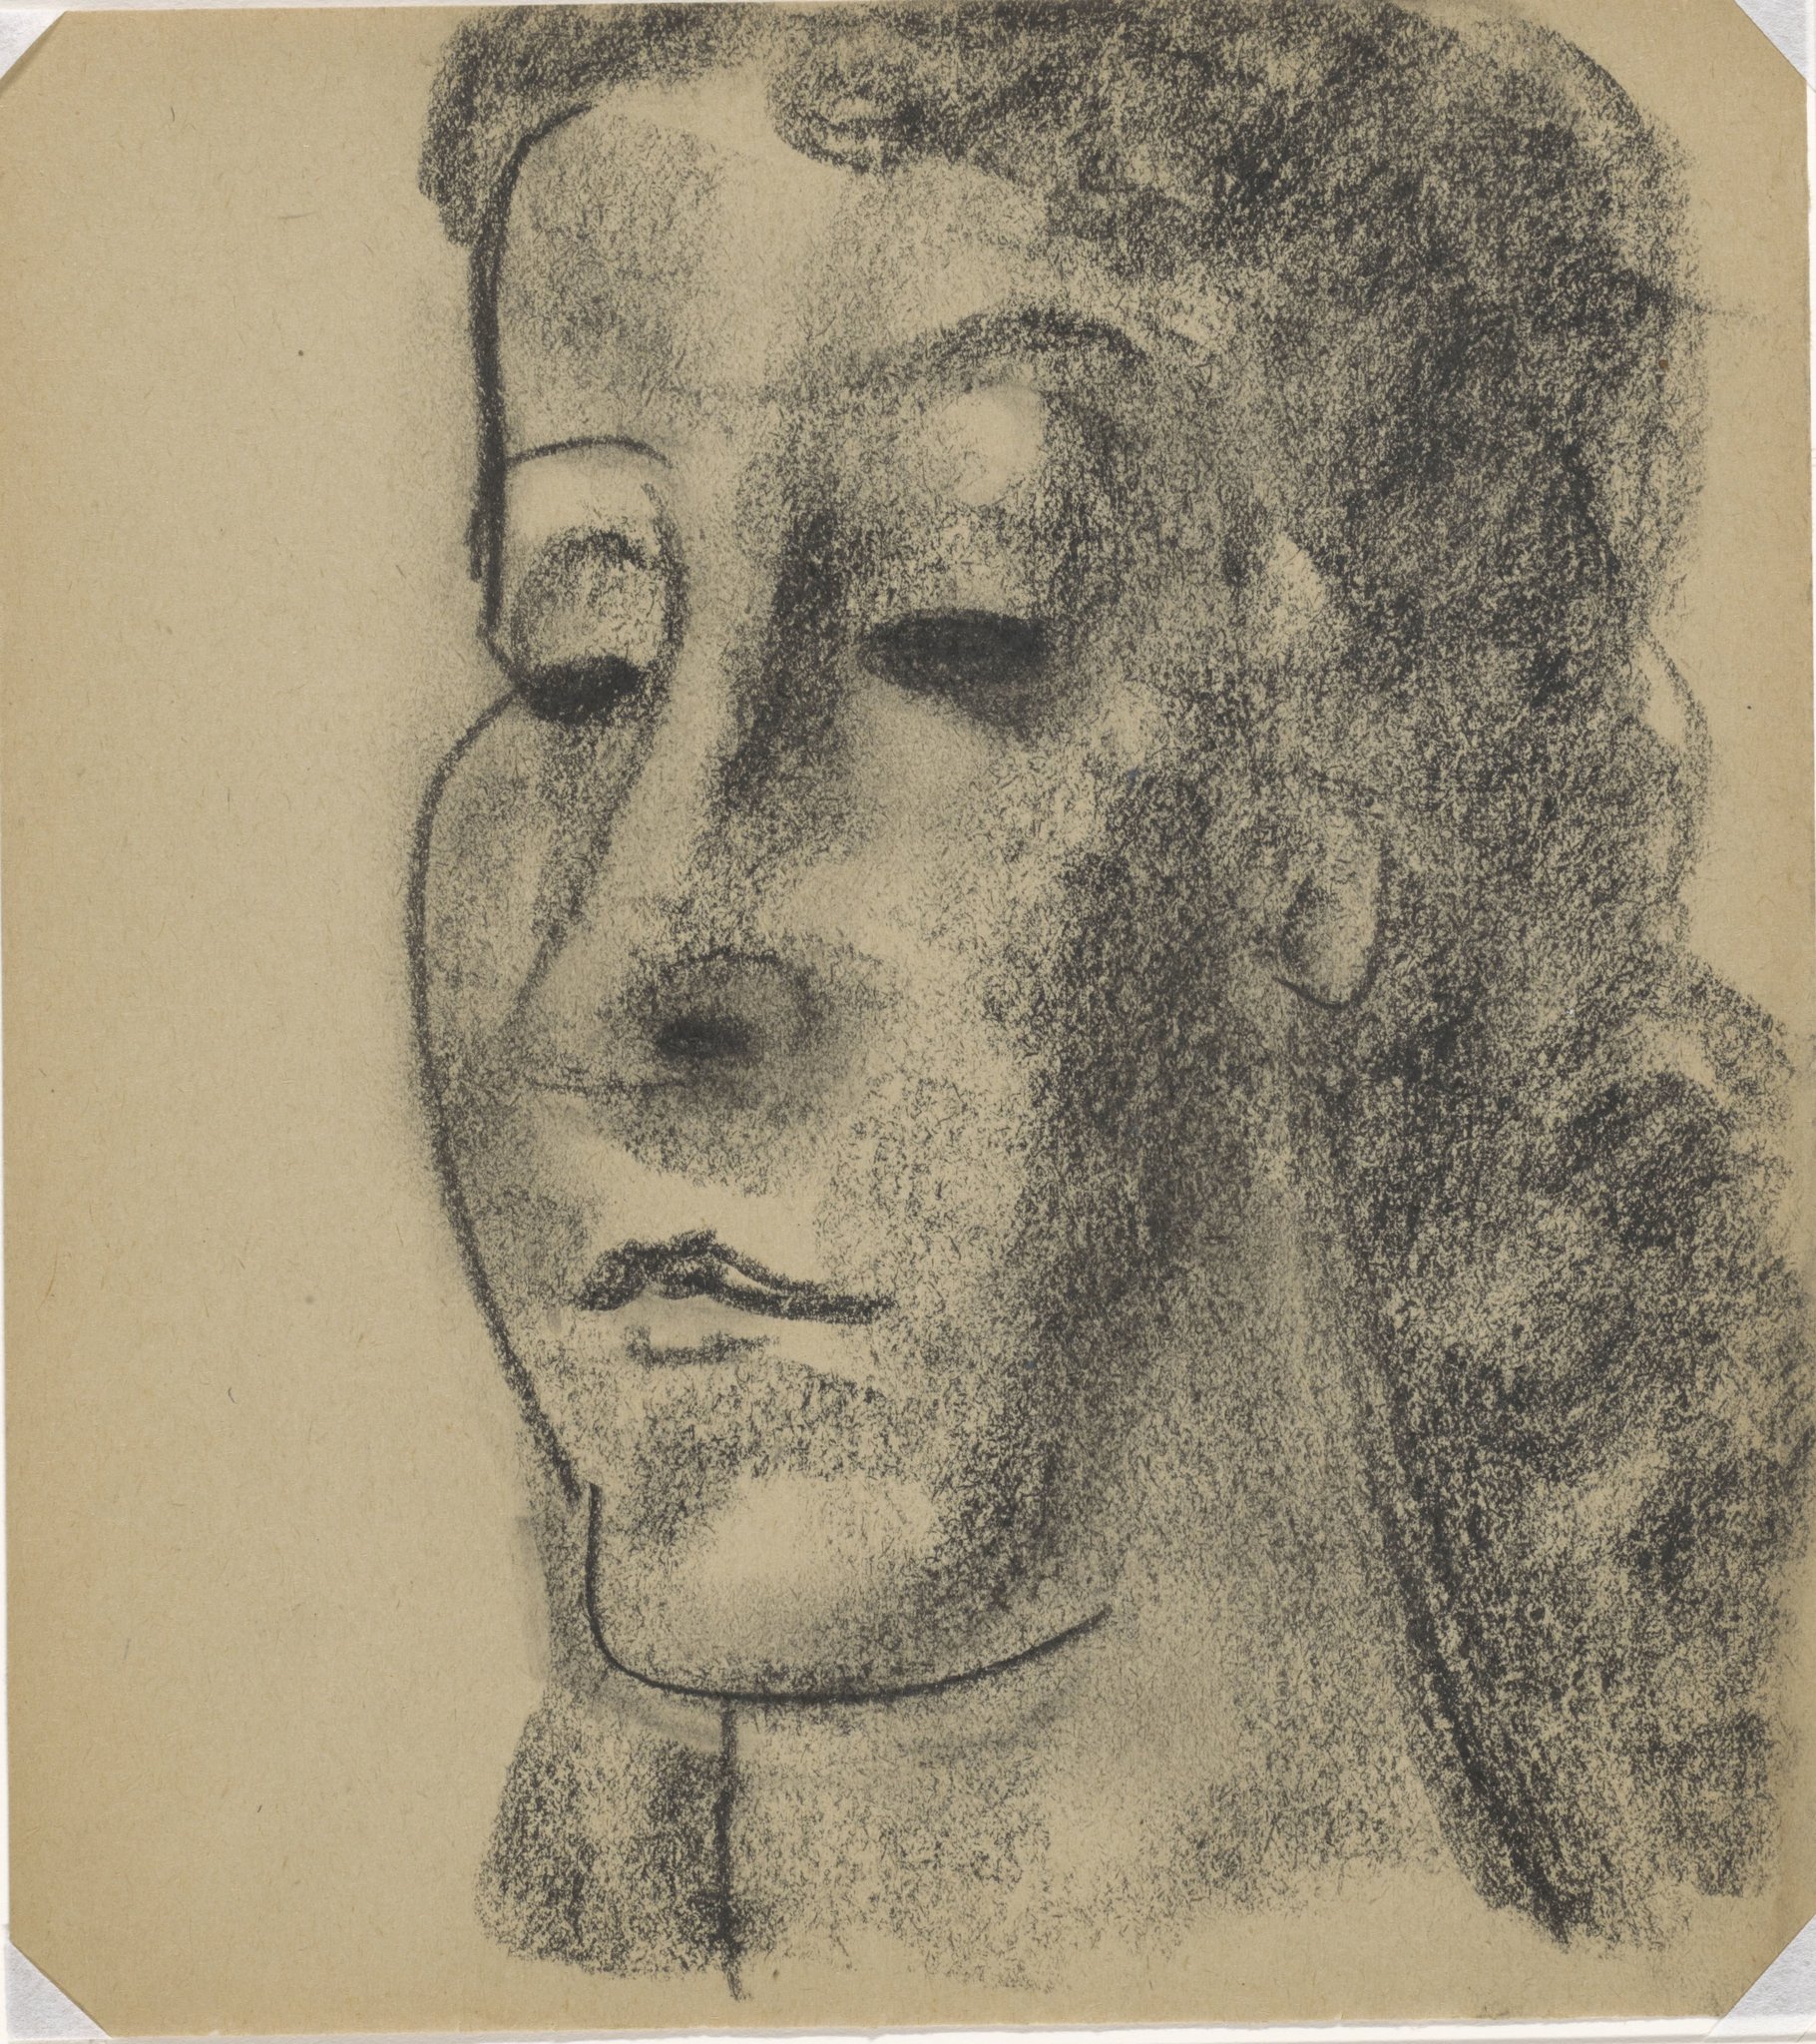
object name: drawing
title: Zonder titel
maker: leo gestel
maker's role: draughtsman, print maker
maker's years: 1881-1941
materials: chalk, paper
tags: anonymous historical person portrayed - bb - woman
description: Portret van een vrouw driekwart naar links met zwart ingevulde ogen en krullend haar.